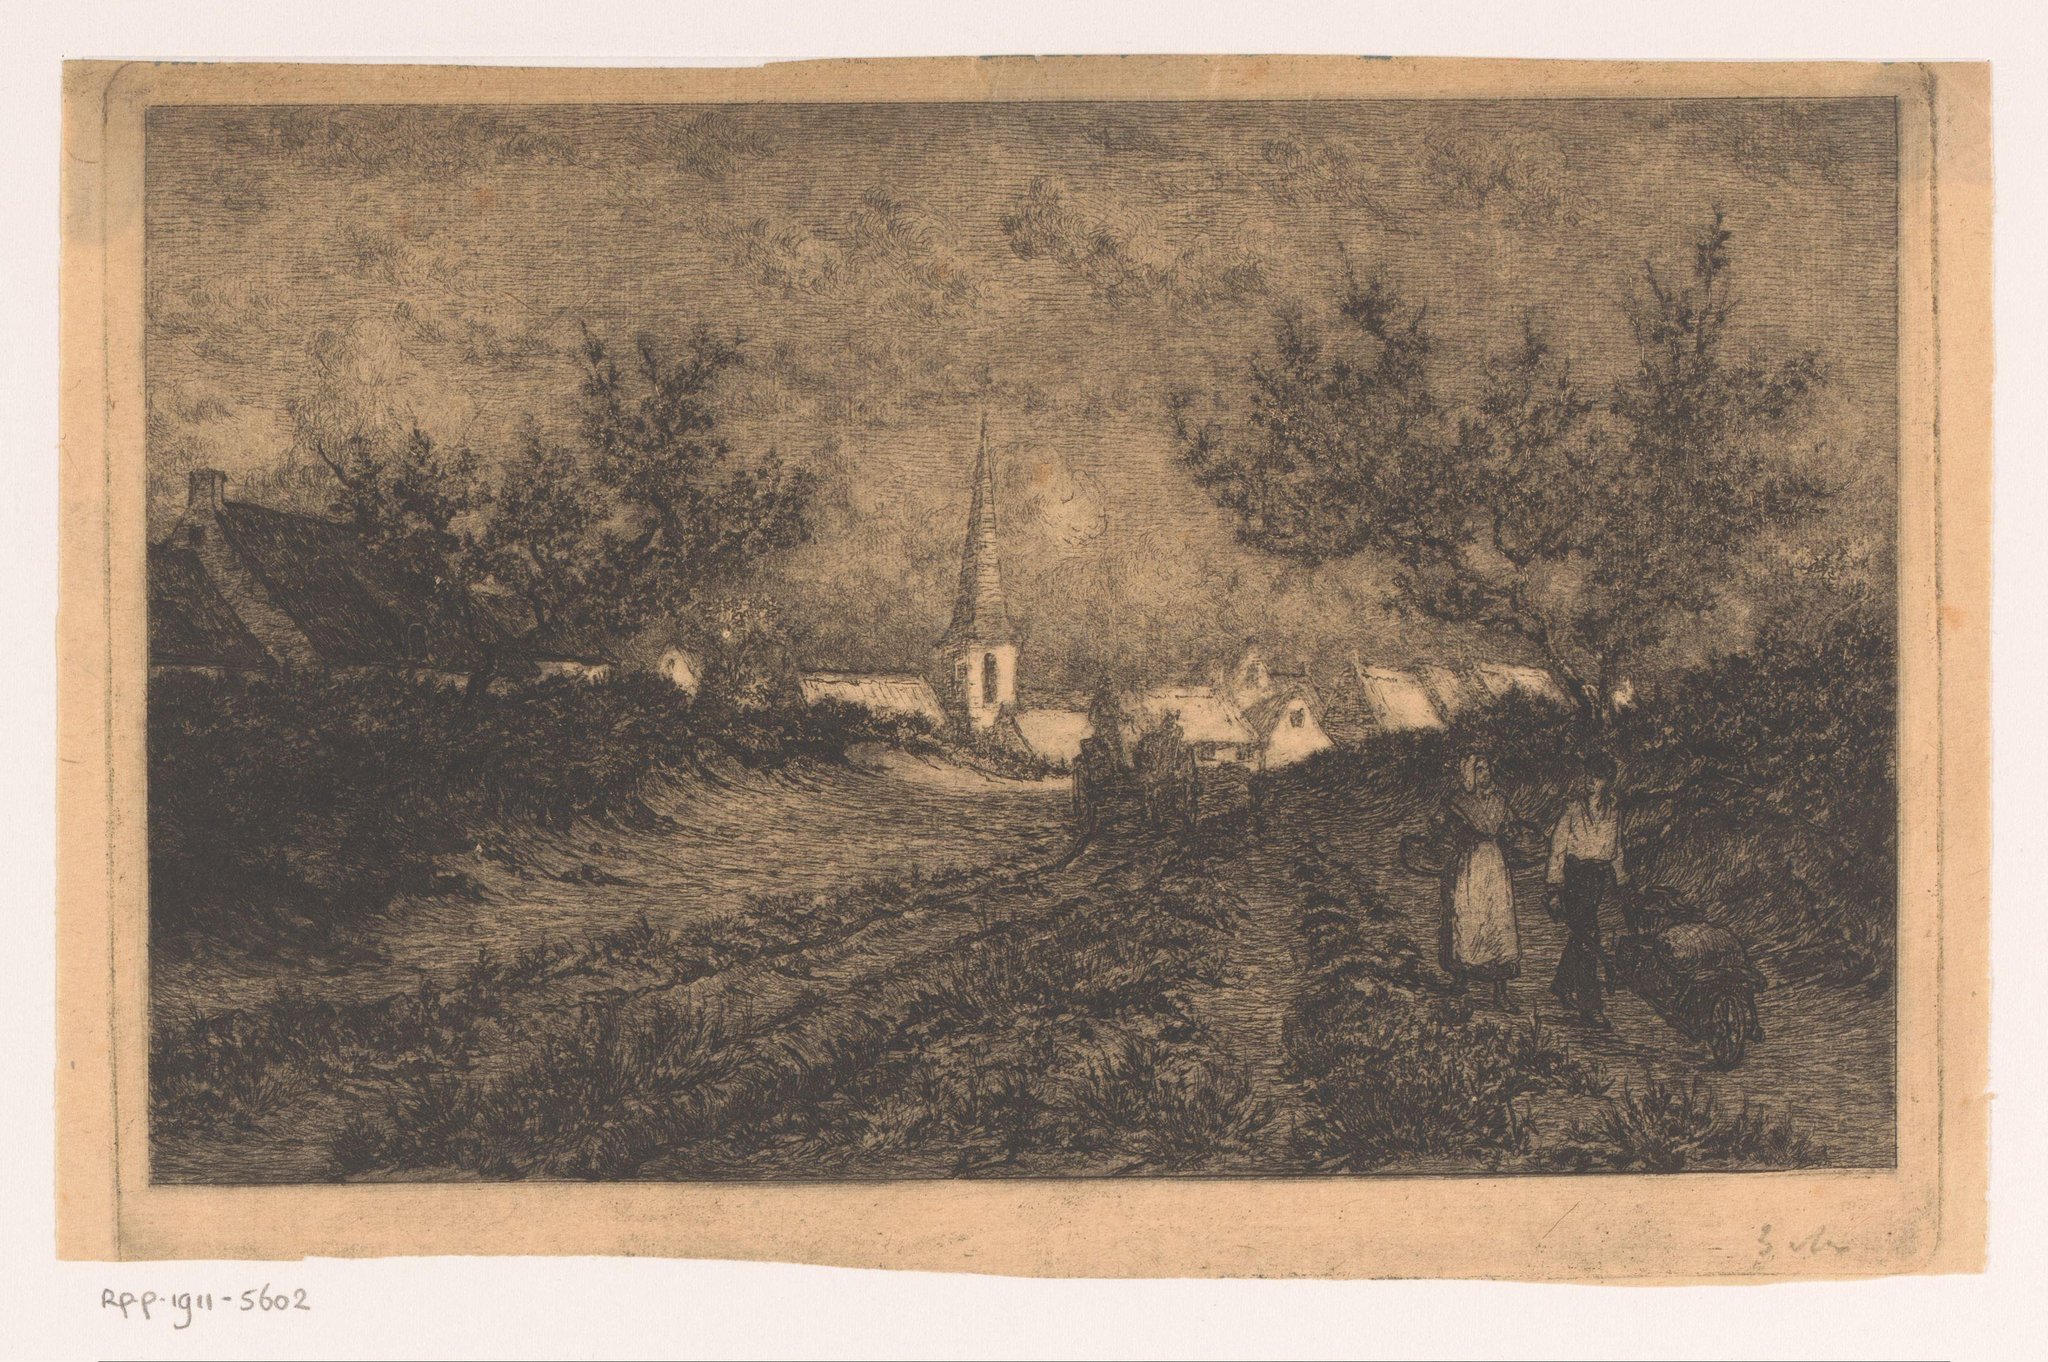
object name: print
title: Dorpsgezicht met landweg in de Kempen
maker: frans van kuyck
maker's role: painter, print maker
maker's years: 1852-1915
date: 1862-1911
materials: paper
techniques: etching, intaglio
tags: prospect of village, silhouette of village, four-wheeled vehicle drawn by one animal, road, path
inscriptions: collector's mark: Lugt 2228